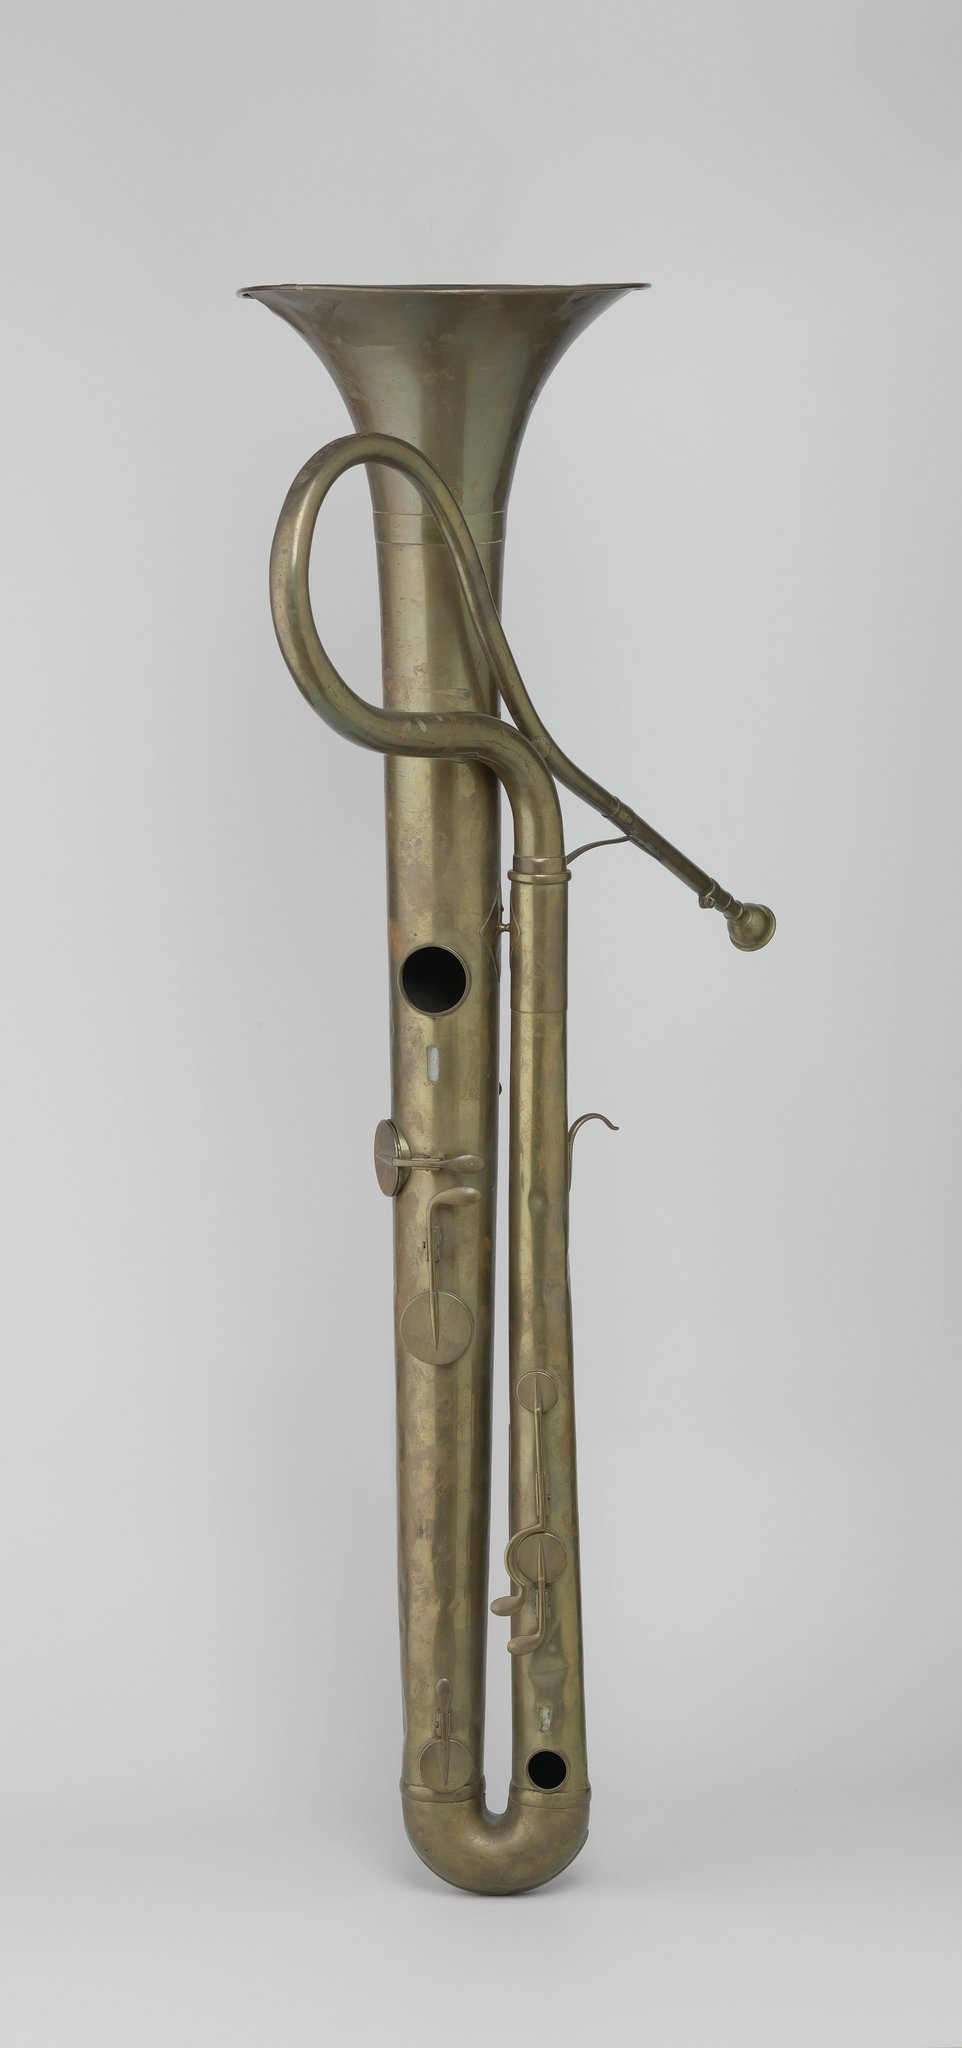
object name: musical instrument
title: Ophicleide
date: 1821-1830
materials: copper, felt, leather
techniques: casting, cutting, woodworking, sawing, soldering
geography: france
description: Koperen blaasinstrument, een soort tuba maar dan met de beker naar voren bestaande uit twee delen. Twee kleppen en het mondstuk horen hier los bij. Rond de beker zit een koperen rand. Aan het instrument is een houder gesoldeerd voor bladmuziek. De binnenzijden van de kleppen zijn bekleed.